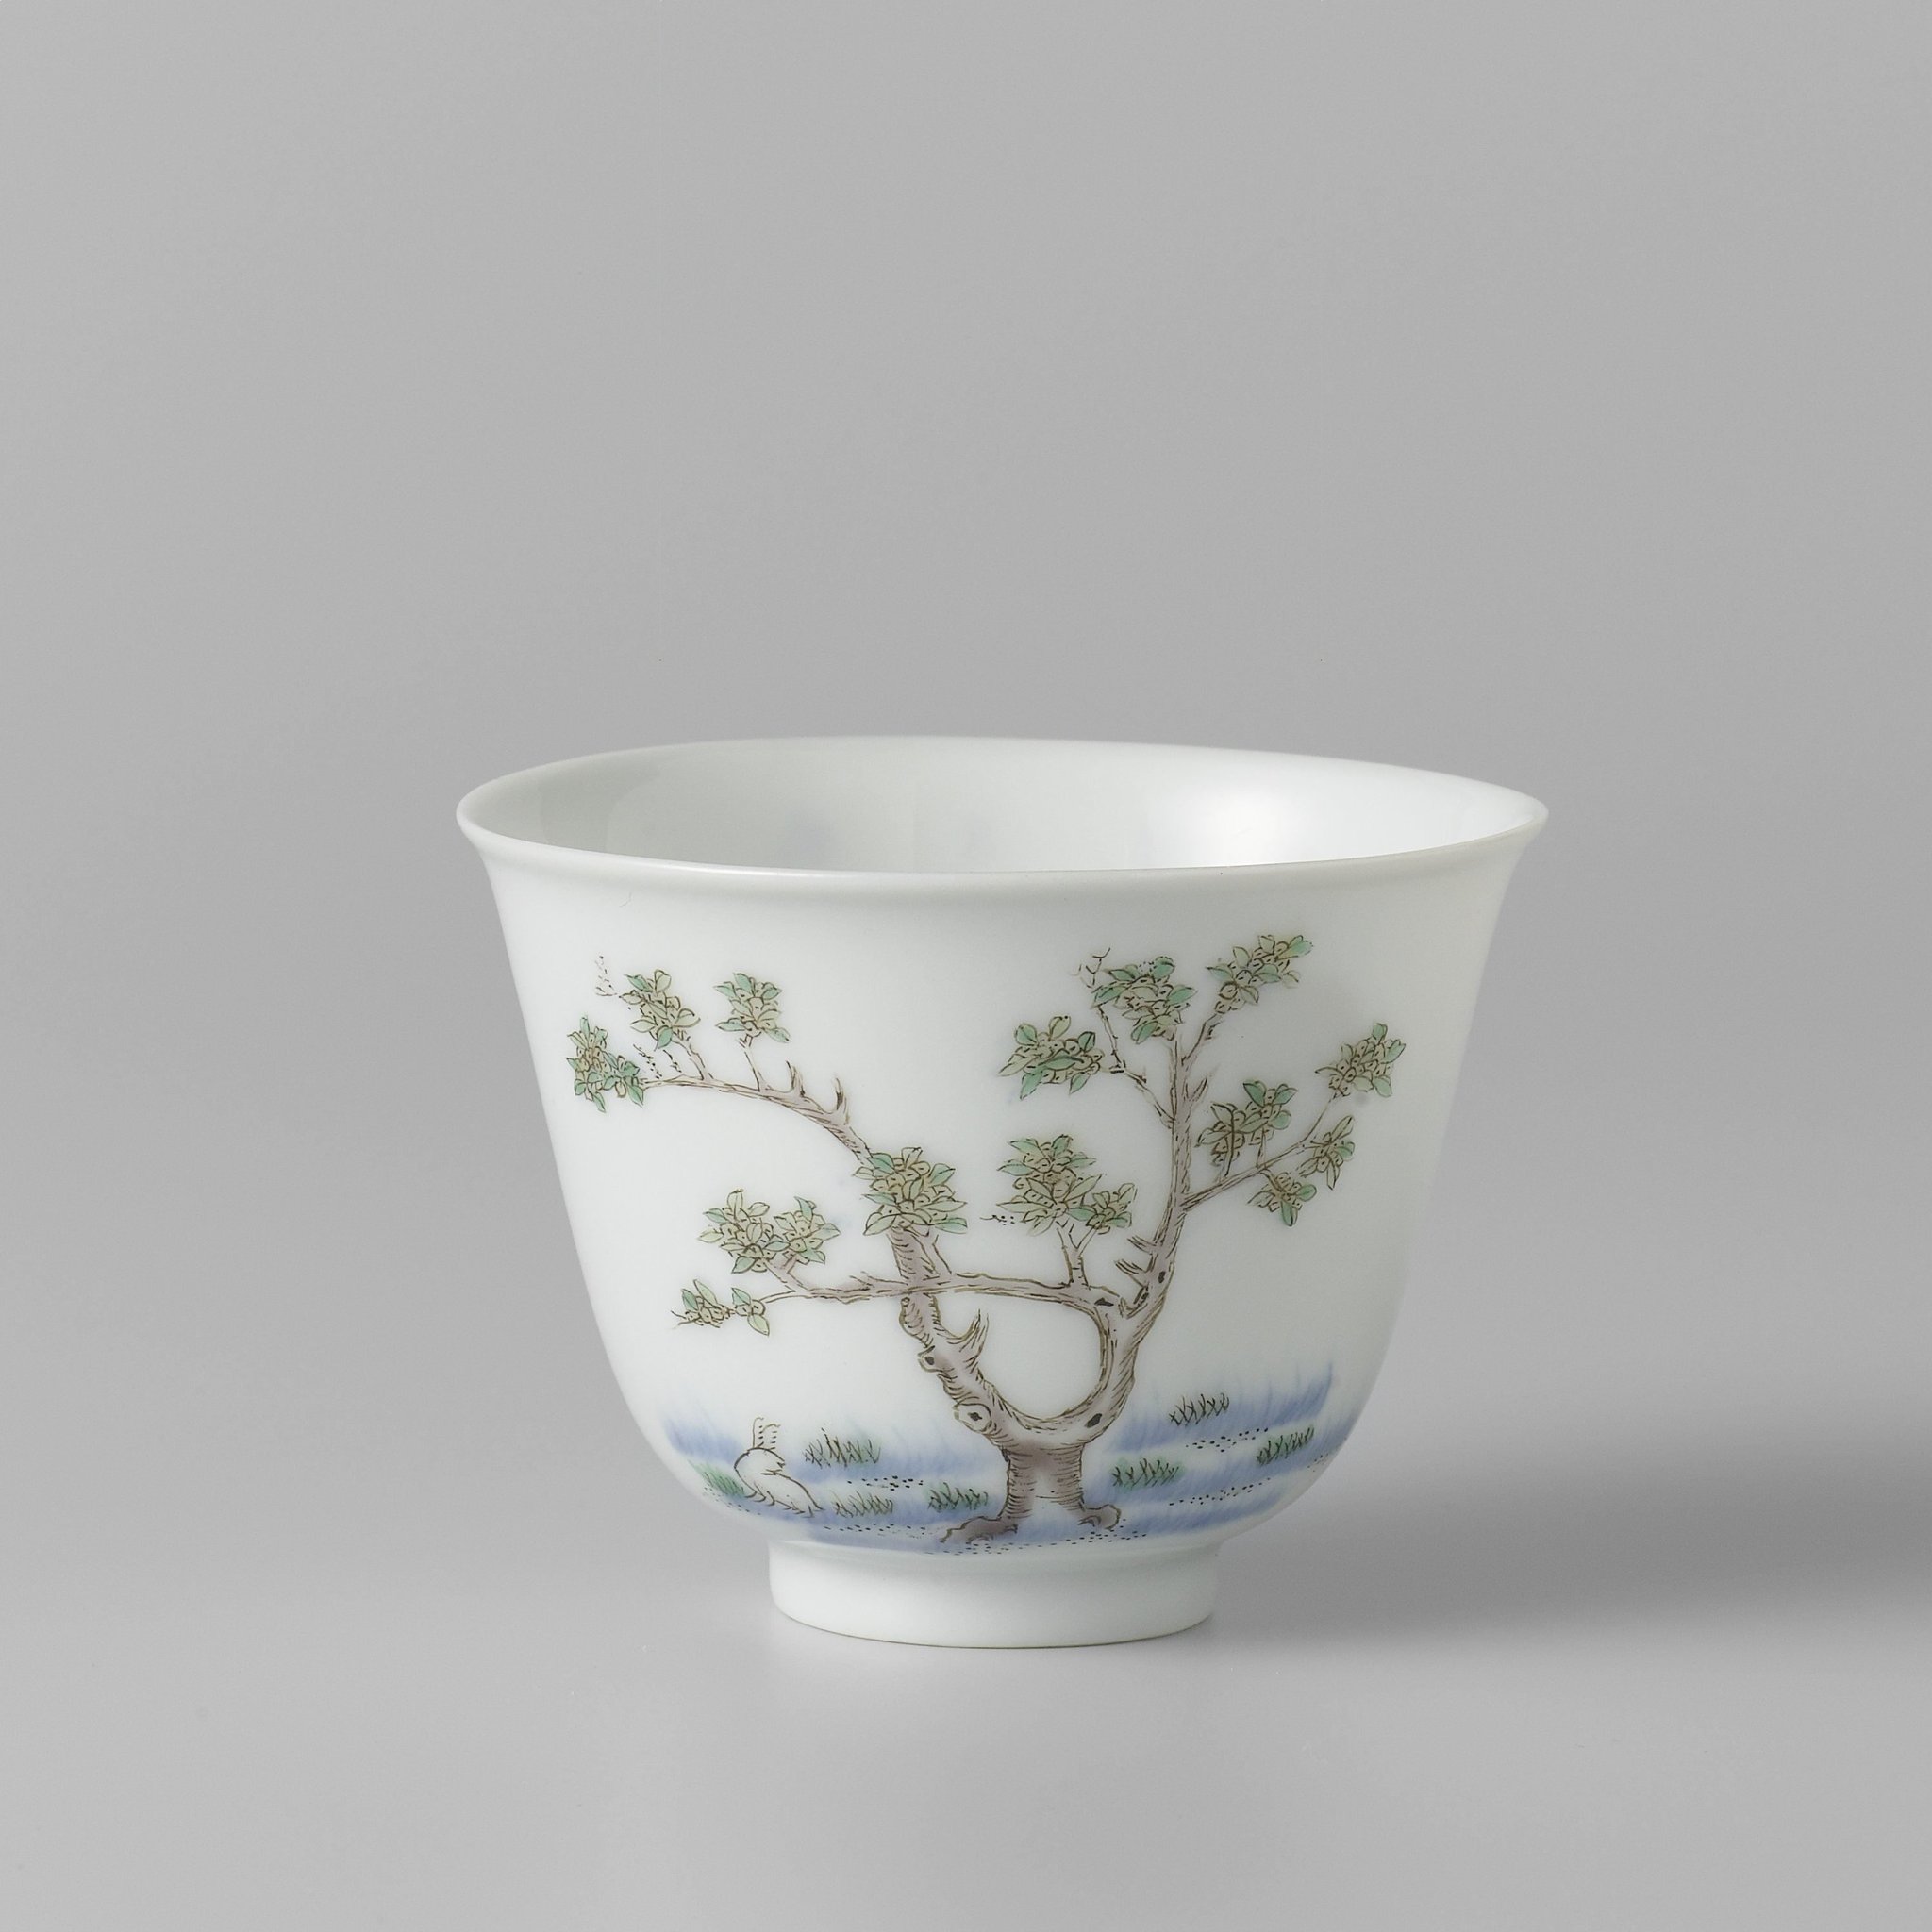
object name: cup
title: Month cup of the eighth month with an osmanthus tree and a poem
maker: Anonymous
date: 1700-1724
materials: cobalt, glaze, paint, porcelain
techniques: firing, turning, vitrification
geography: china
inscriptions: mark: ‘大 清 康 熙 年 製’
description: Klokvormige kop van porselein, beschilderd in onderglazuur blauw en op het glazuur blauw, rood, groen, geel, aubergine en zwart. Maandkopje van de achtste maand met op de buitenwand een osmanthusboom en een tweeregelig gedicht afgesloten door het zegelmerk 'shang', waardering. Gemerkt op de onderzijde met het zes-karaktermerk van keizer Kangxi in een dubbele cirkel. Porselein met emailkleuren.